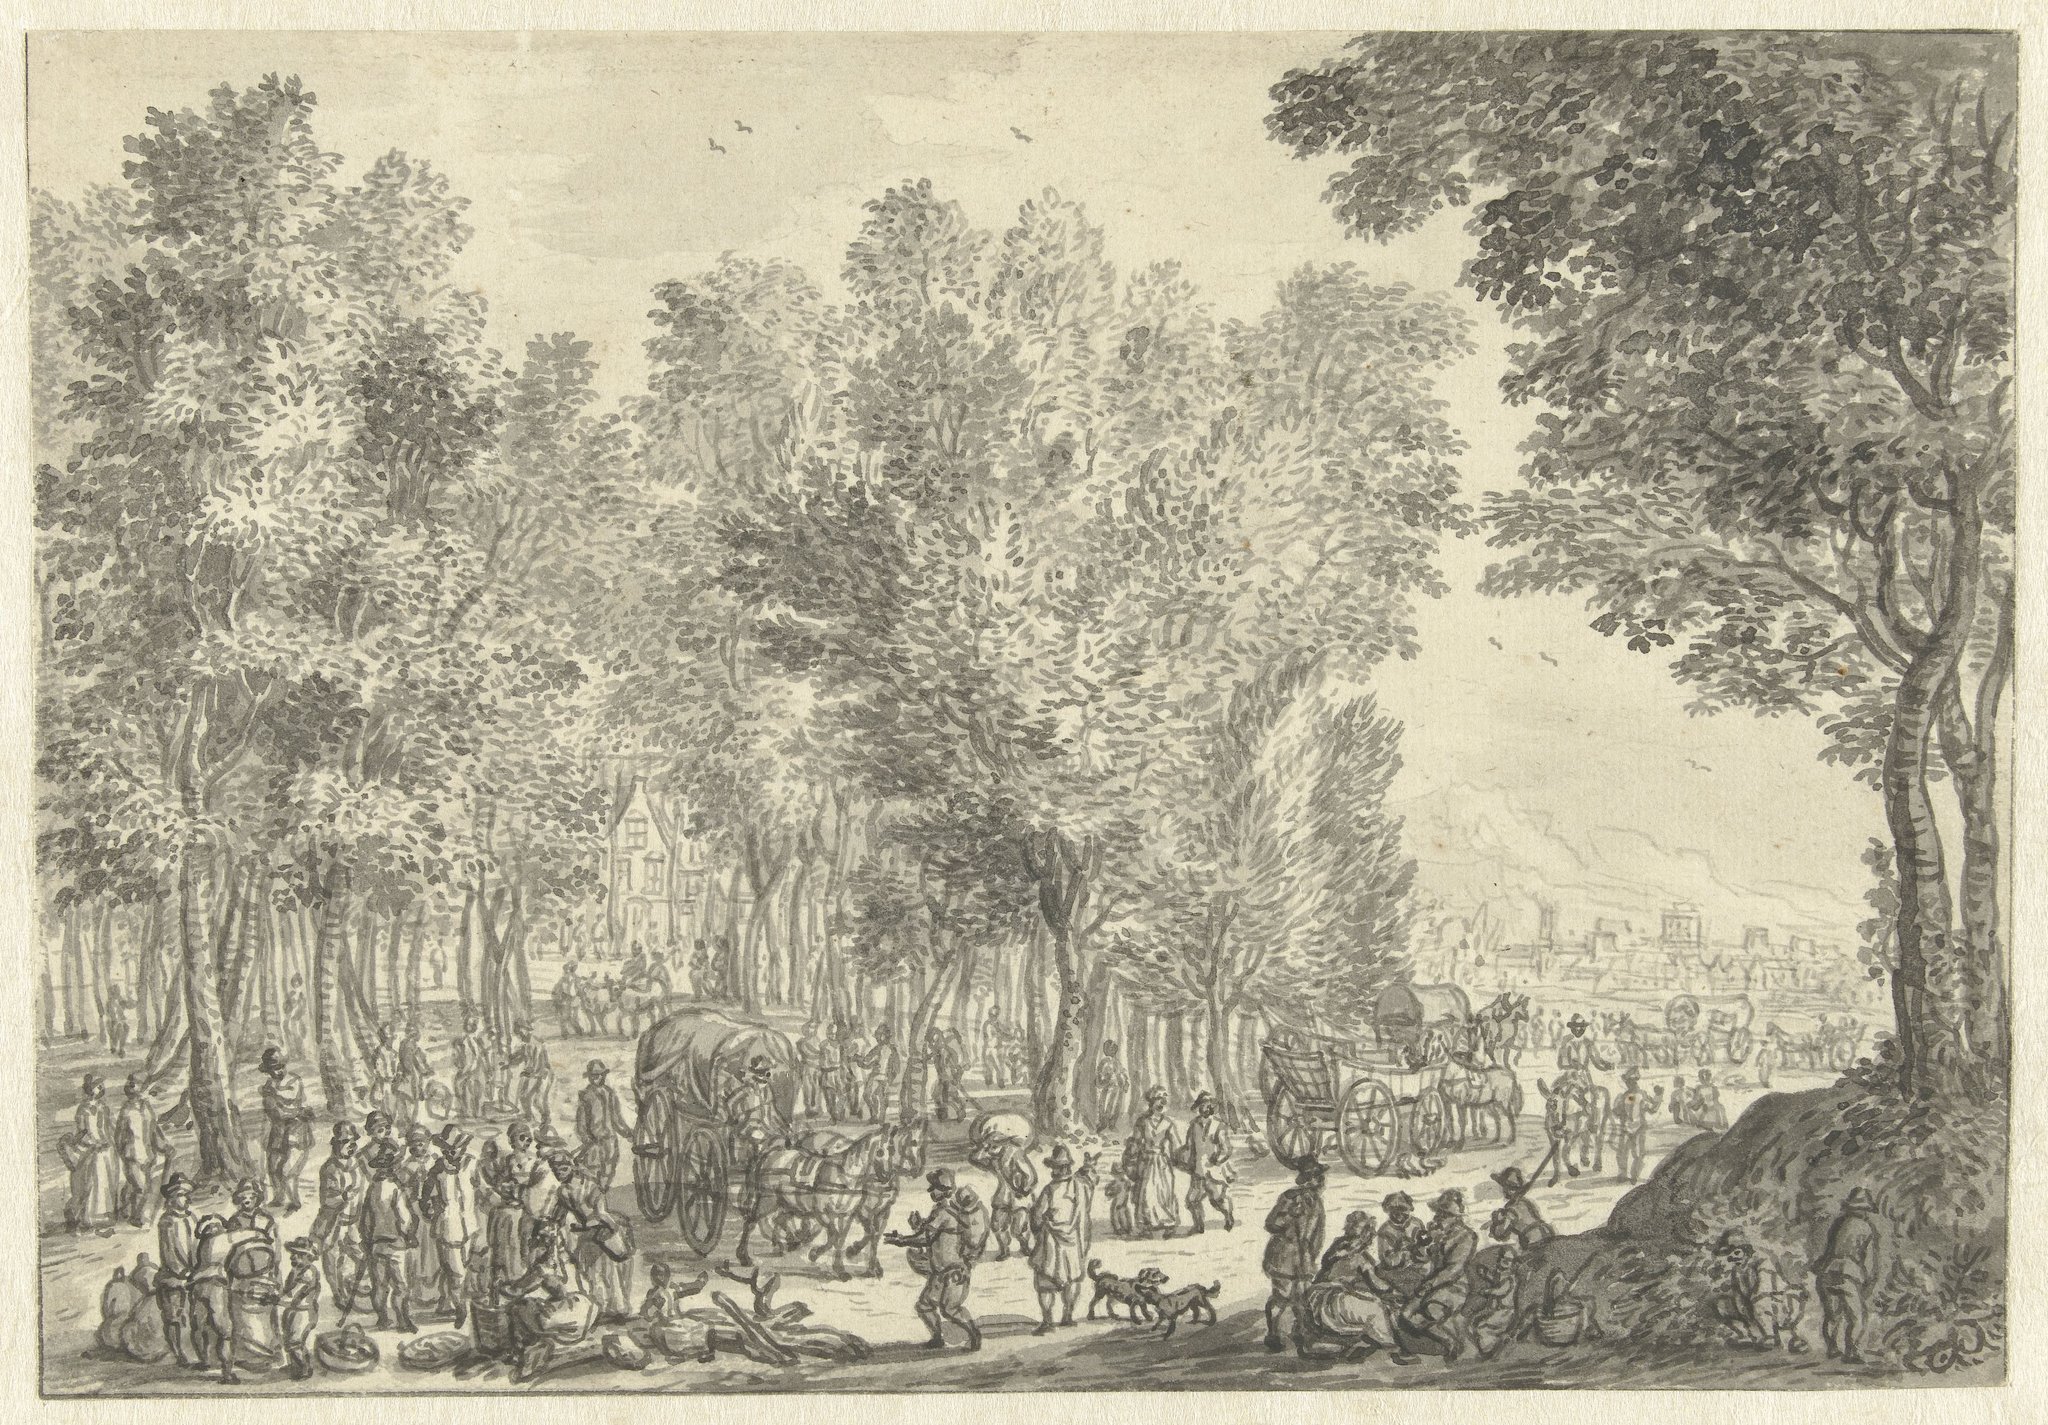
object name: drawing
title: Jaarmarkt onder bomen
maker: hendrik soukens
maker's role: draughtsman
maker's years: 1680-1711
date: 1700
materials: paper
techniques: brush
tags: market